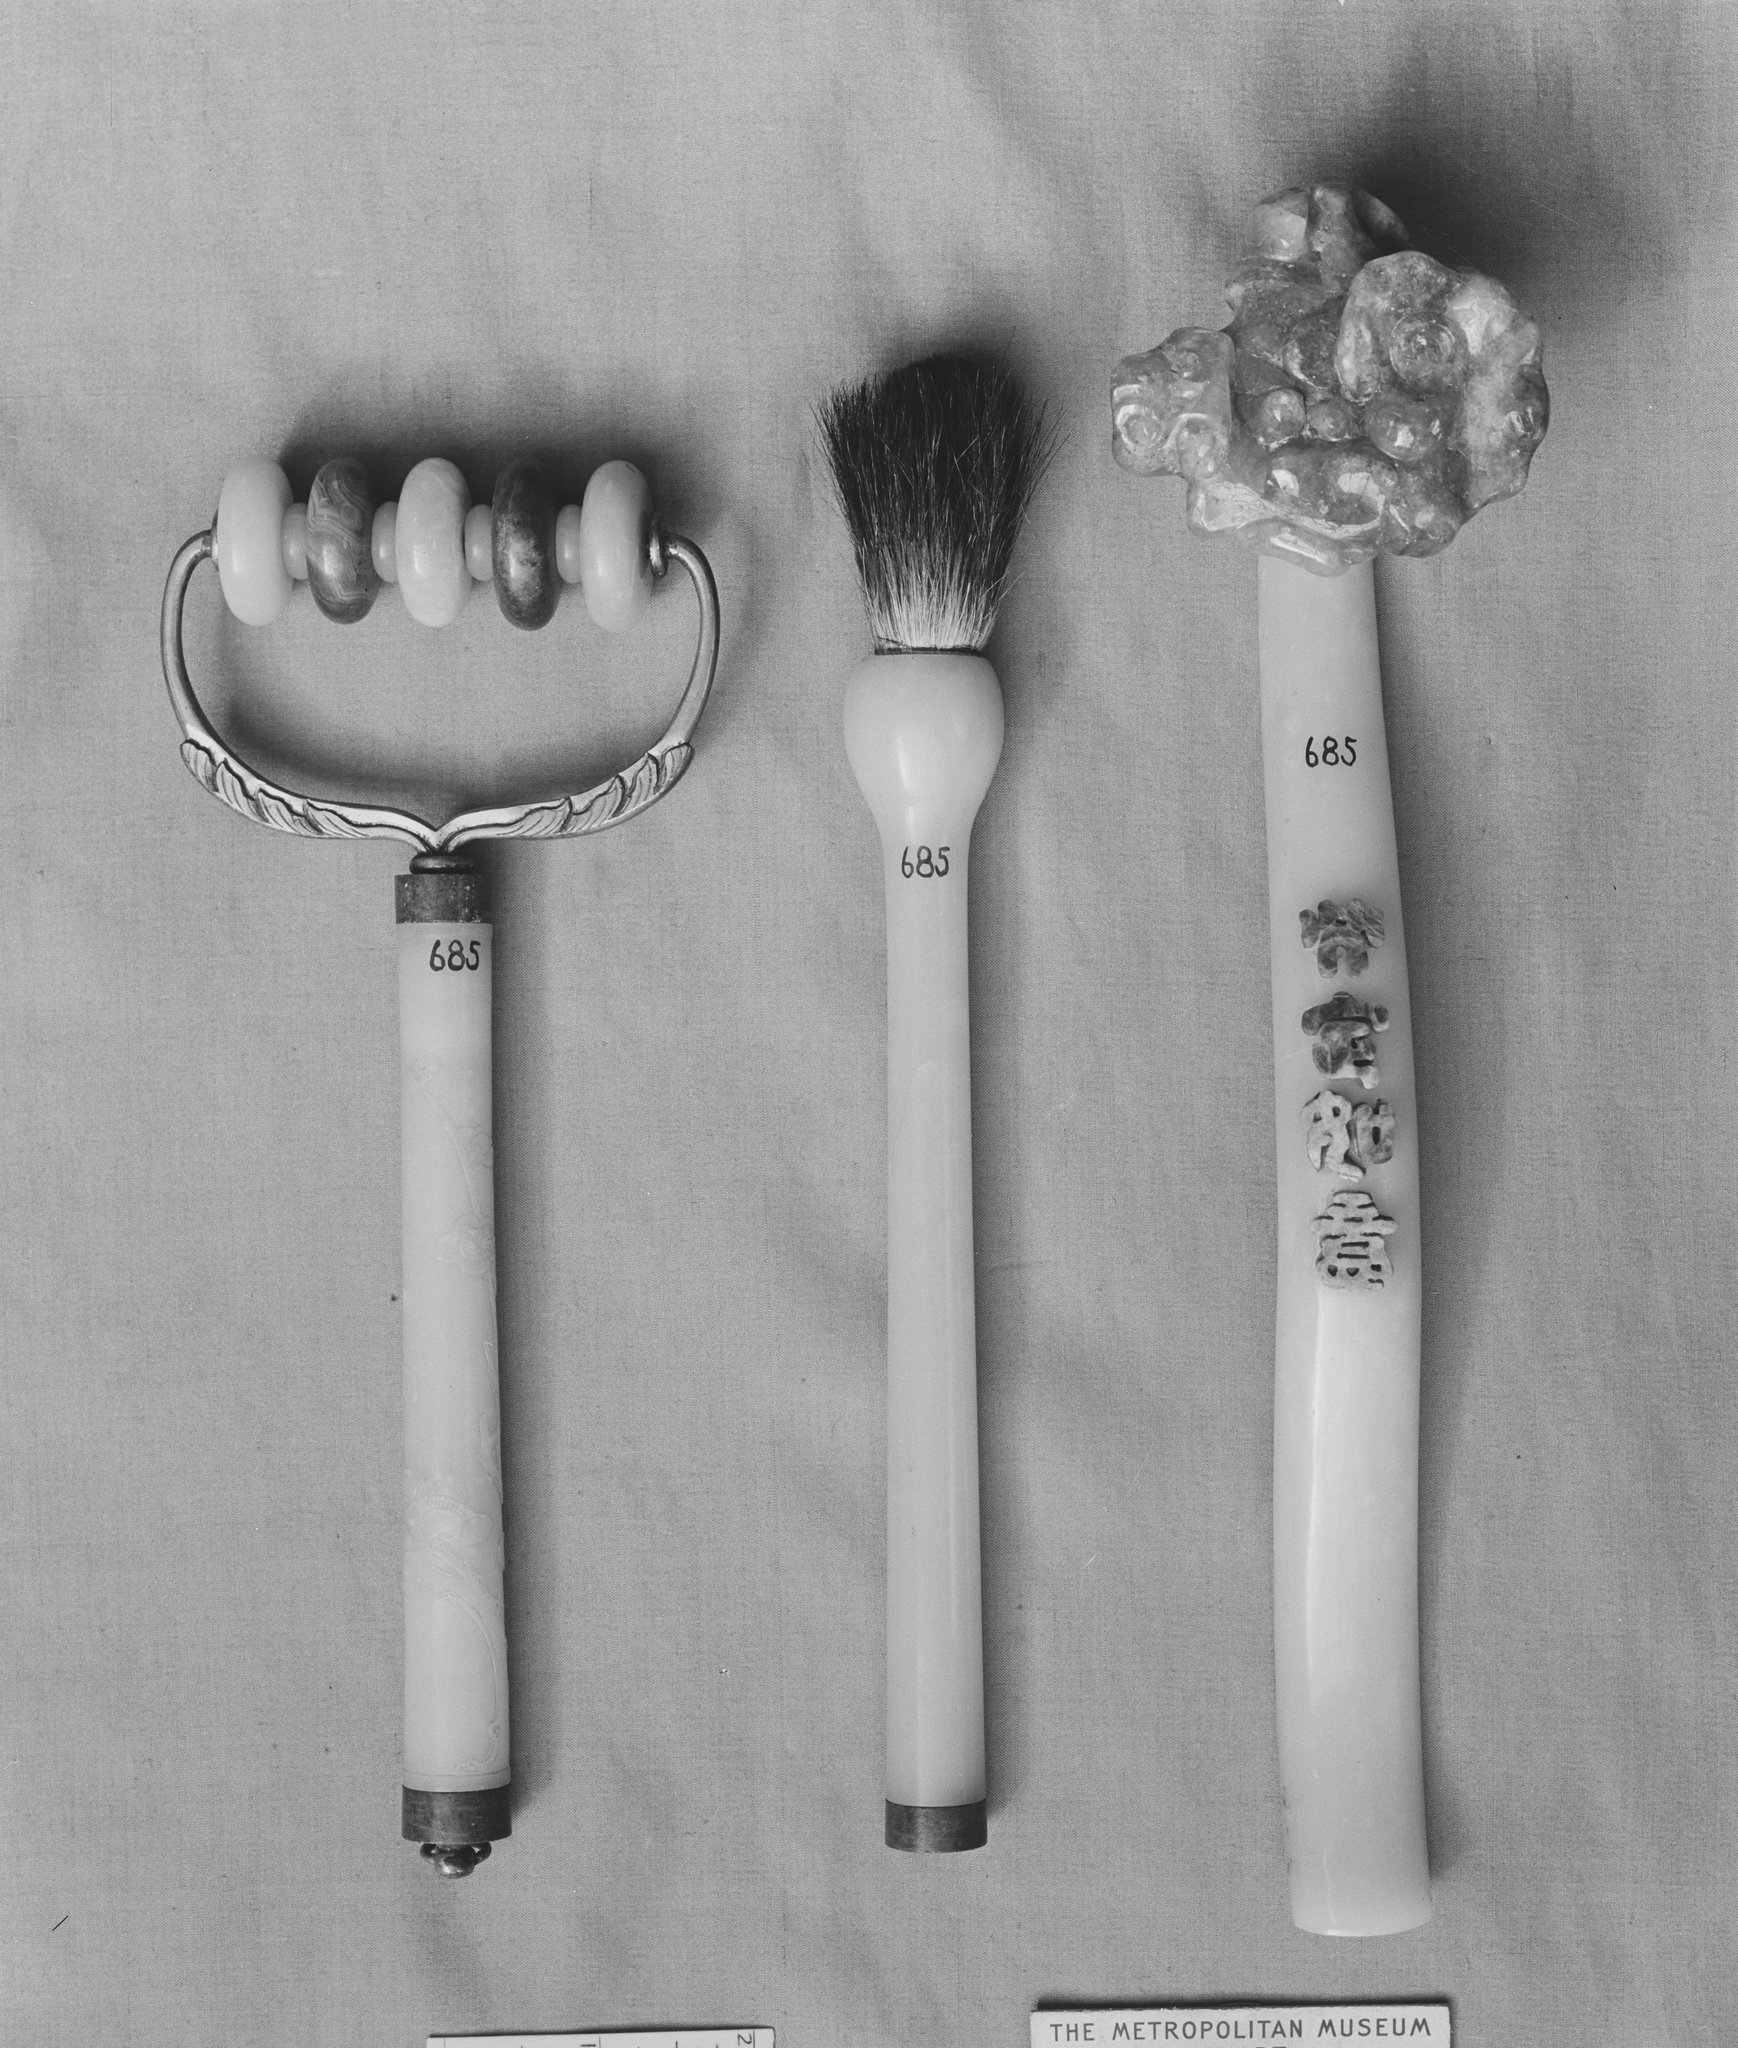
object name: massage implement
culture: chinese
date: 1701-1800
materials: stone, gemstone, jade, lapis lazuli